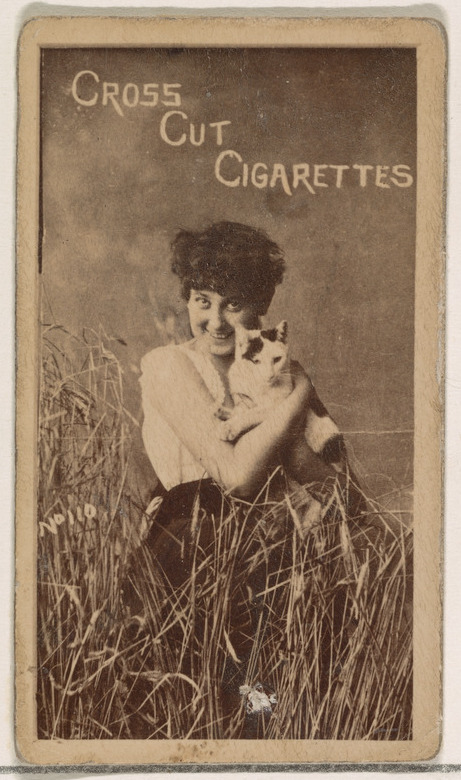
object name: print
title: Card Number 110, Geraldine Ulmer, from the Actors and Actresses series (N145-1) issued by Duke Sons & Co. to promote Cross Cut Cigarettes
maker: w. duke, sons & co.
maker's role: publisher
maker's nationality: american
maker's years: 1870-1920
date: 1880-1889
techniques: albumen silver print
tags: portraits,women,cats,actresses